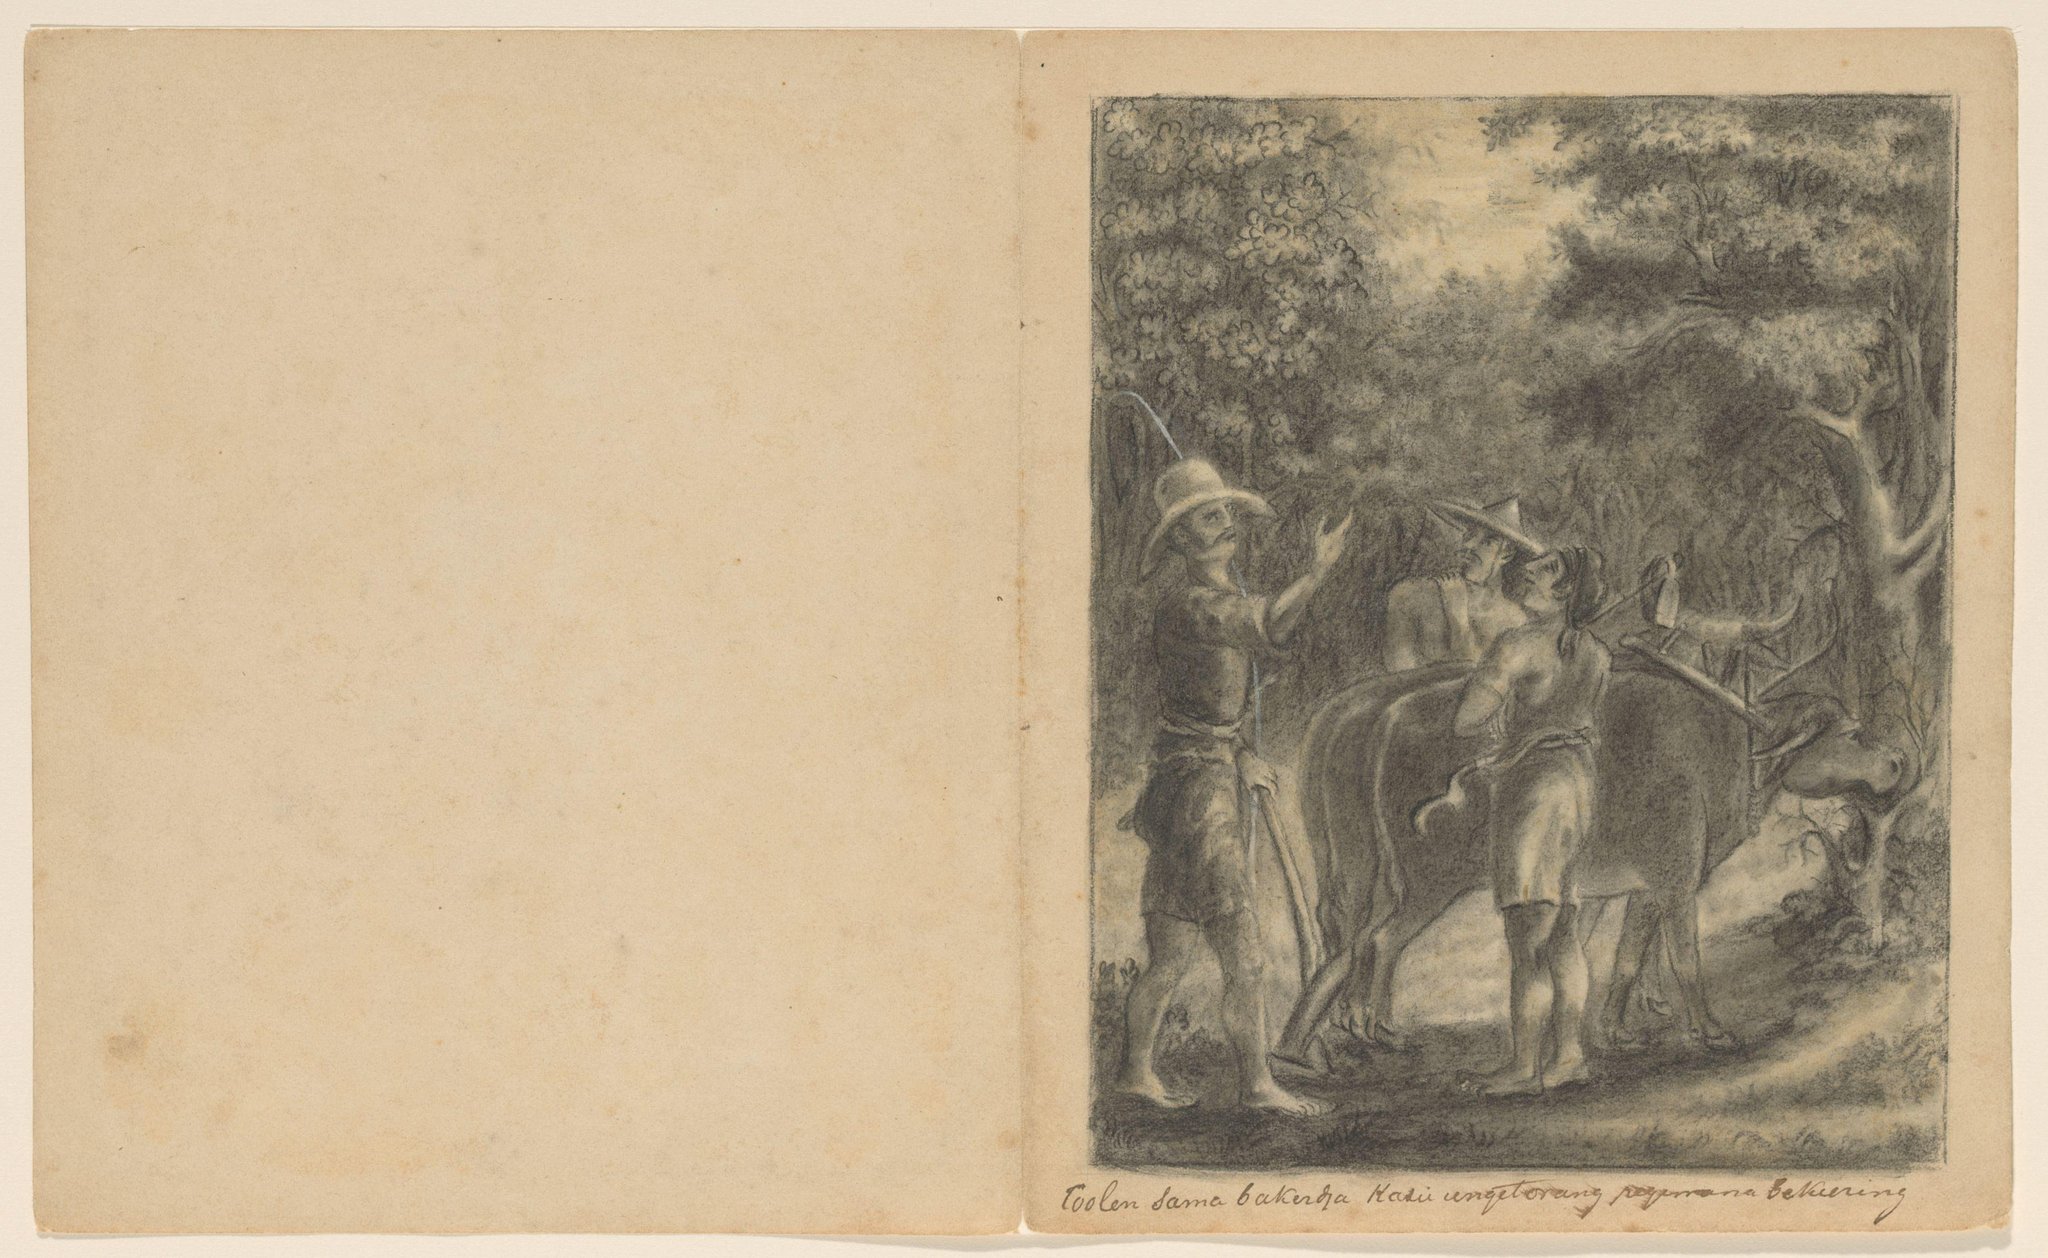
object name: drawing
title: Coolen spreekt met de mensen over bekering, ca. 1820-1850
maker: Anonymous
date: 1850-1950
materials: chalk, paper, pencil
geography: indonesia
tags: coenraad laurens coolen, oost-java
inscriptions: collector's mark: Lugt 2228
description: Coolen spreekt met de mensen over bekering. Onderdeel van een groep van twaalf losse bladen uit een schetsboek met tekeningen over het leven van Coenraad Laurens Coolen, evangelist op Oost-Java, ca. 1820-1850. Elk blad heeft een tekening op de rechterhelft, met een onderschrift in het Indonesisch.